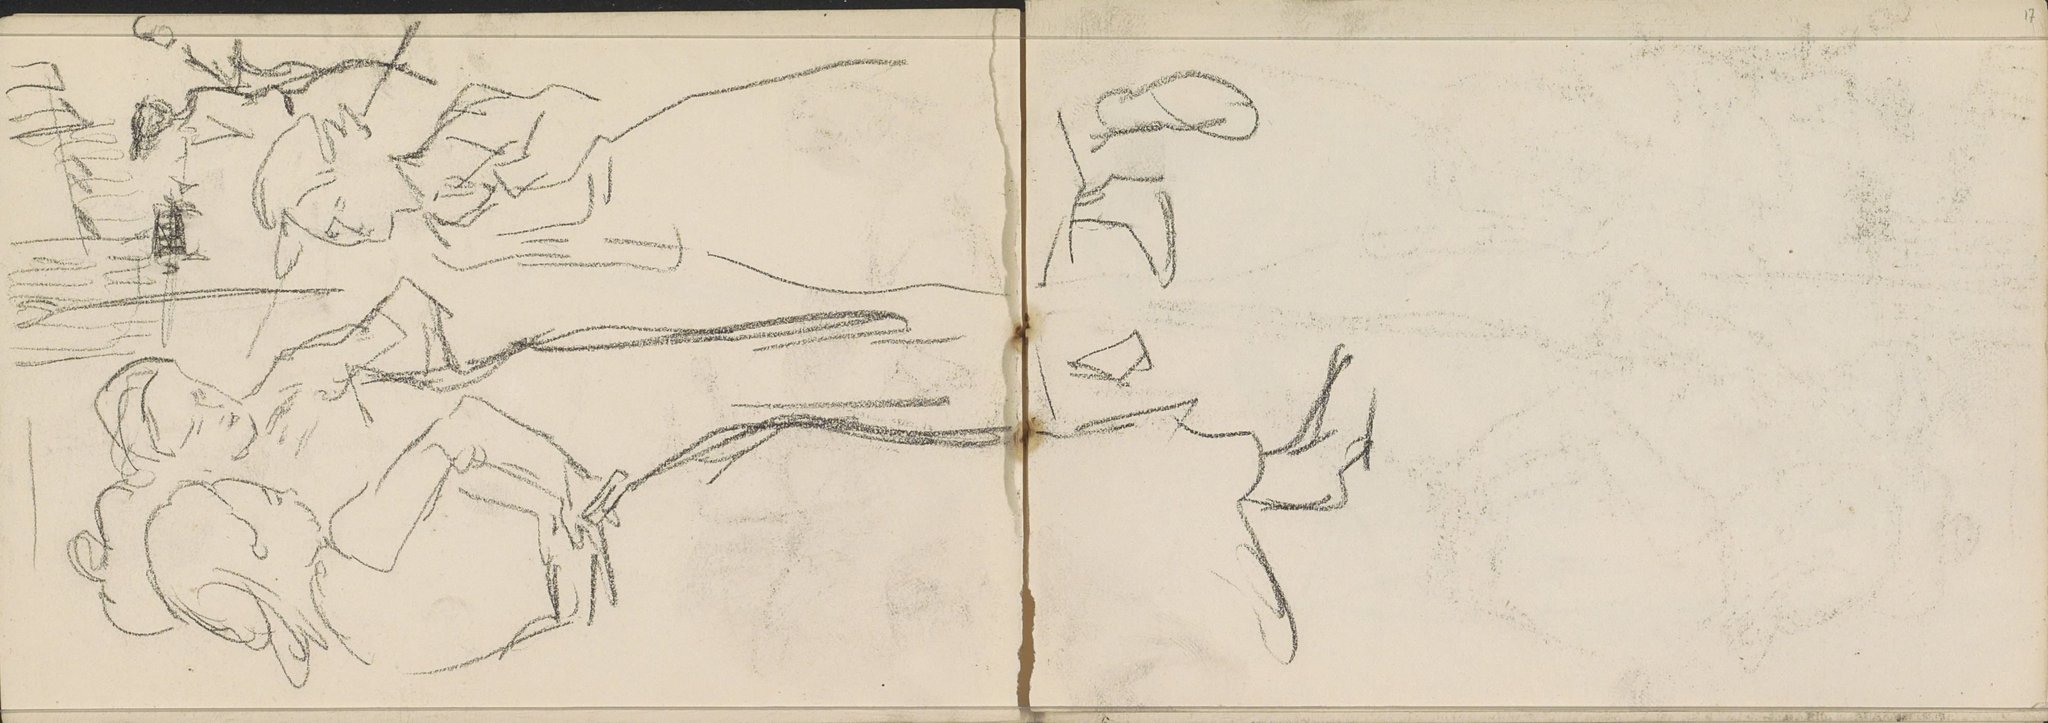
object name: sketchbook leaf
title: Drie vrouwen en een meisje op straat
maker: isaac israels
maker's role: draughtsman, painter, print maker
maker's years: 1865-1934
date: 1875-1934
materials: chalk, paper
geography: the hague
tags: adult woman, girl (child between toddler and youth), street (+ city(-scape) with figures, staffage)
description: Op de achtergrond nog twee figuren en een rijtuig. Pagina 16 en pagina 17 uit schetsboek XLII met 32 pagina's.